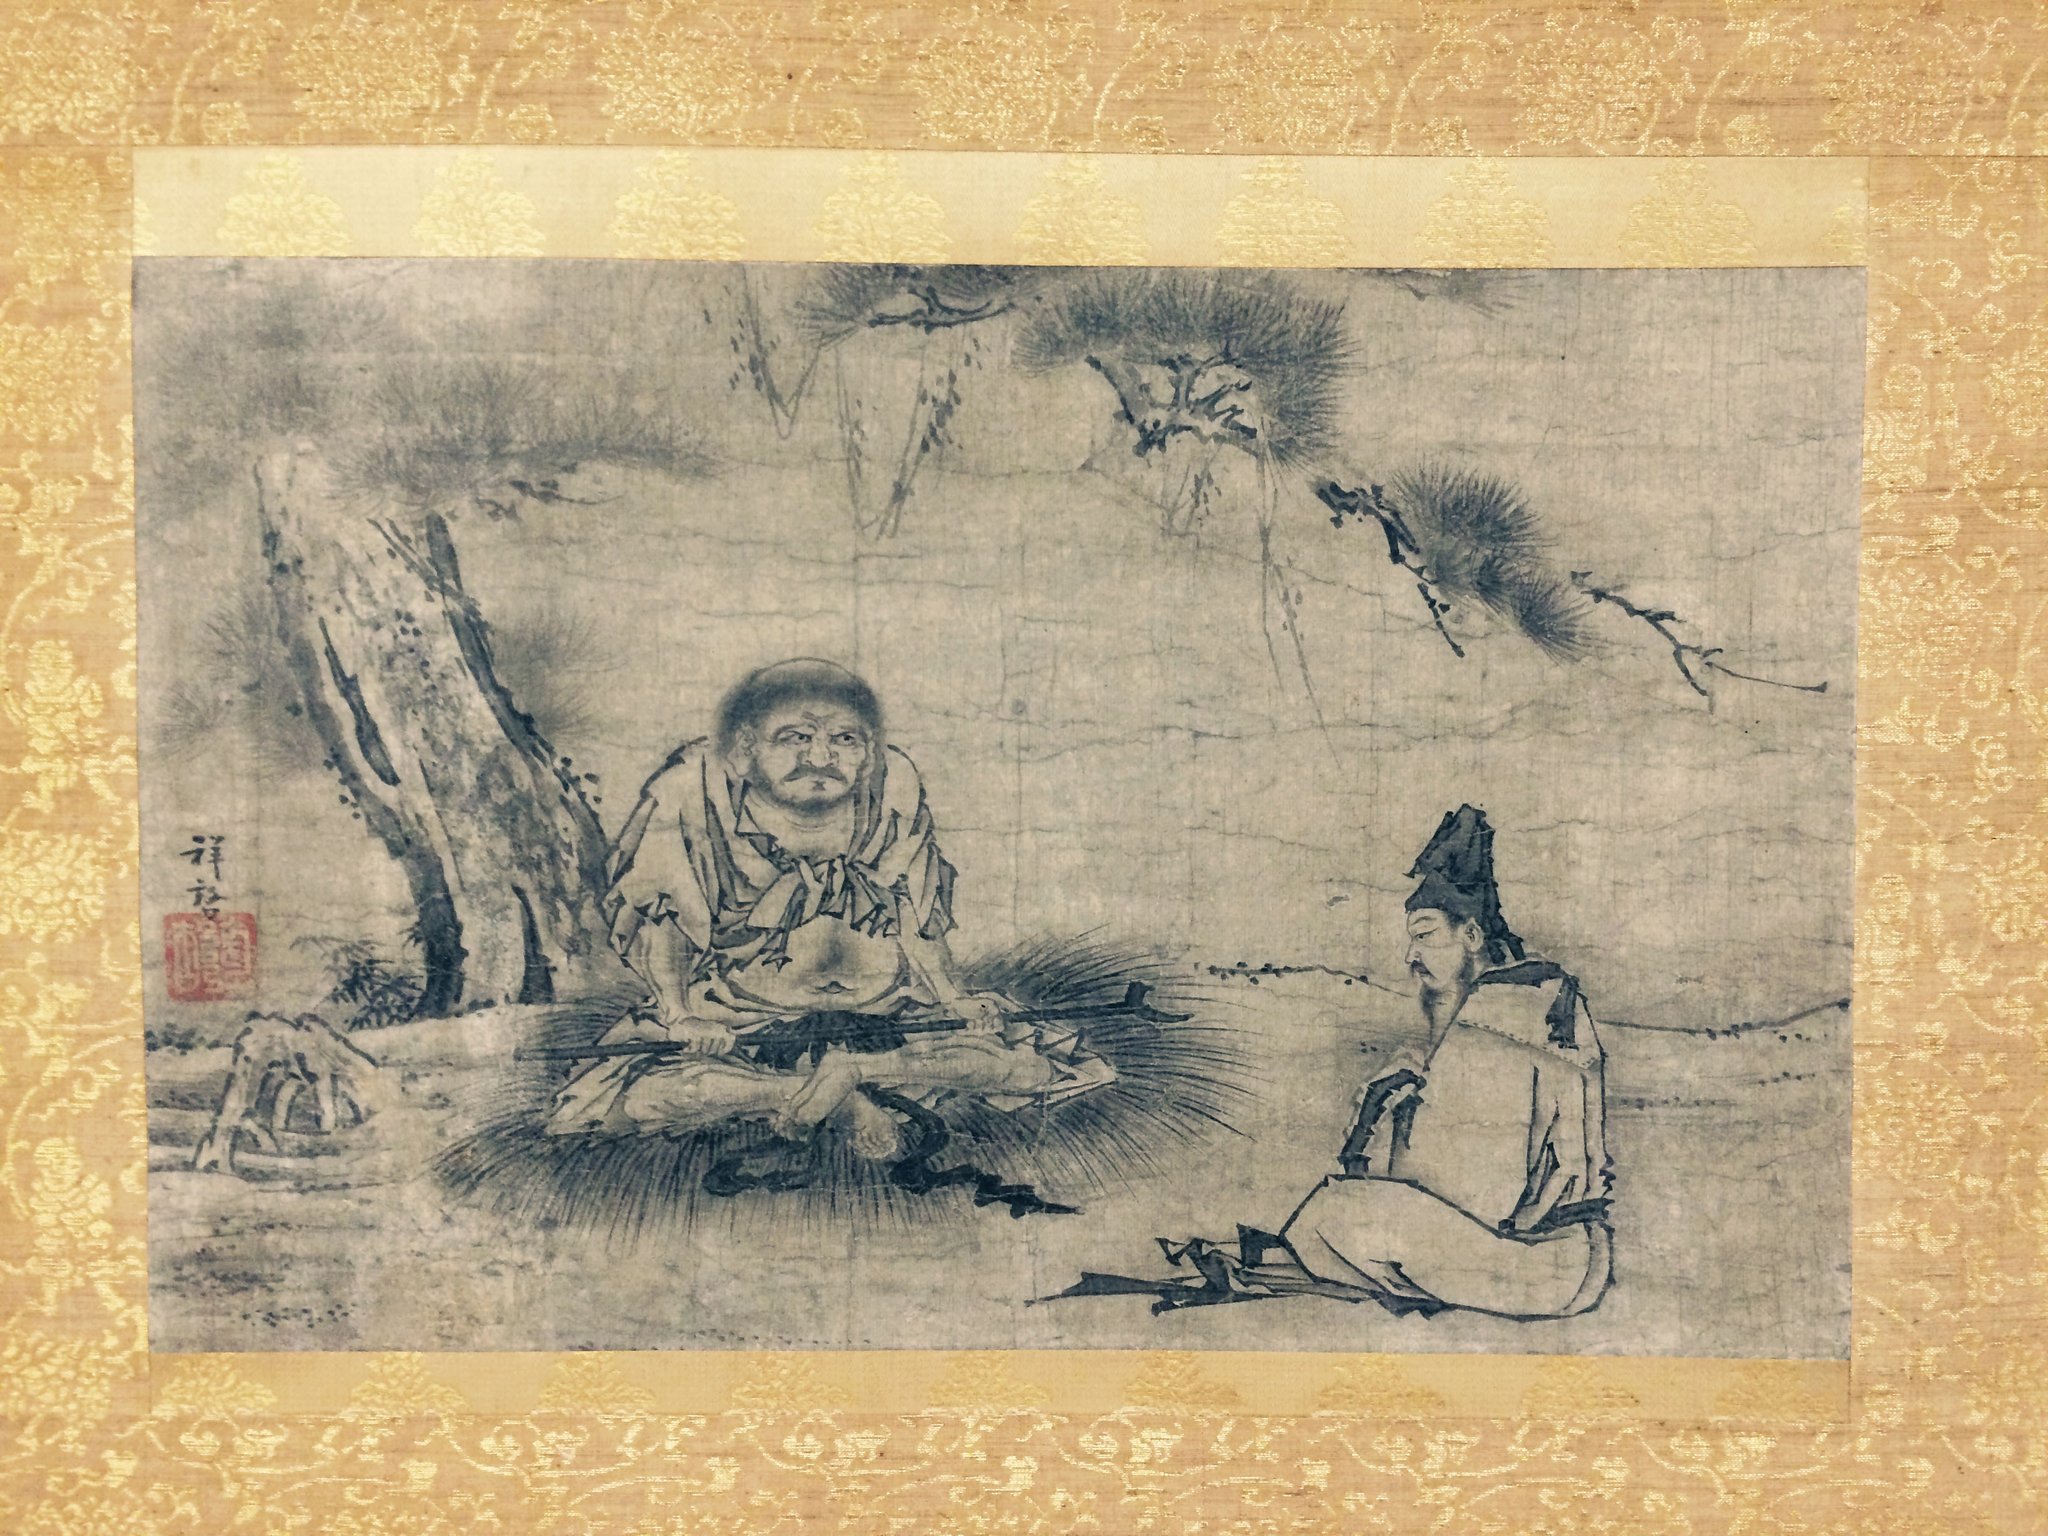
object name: hanging scroll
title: Zen Encounter (Niaoke Daolin and Bai Juyi)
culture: japanese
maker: kenkō shōkei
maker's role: artist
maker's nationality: japanese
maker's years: 1478-1523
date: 1501-1600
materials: ink, paper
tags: men